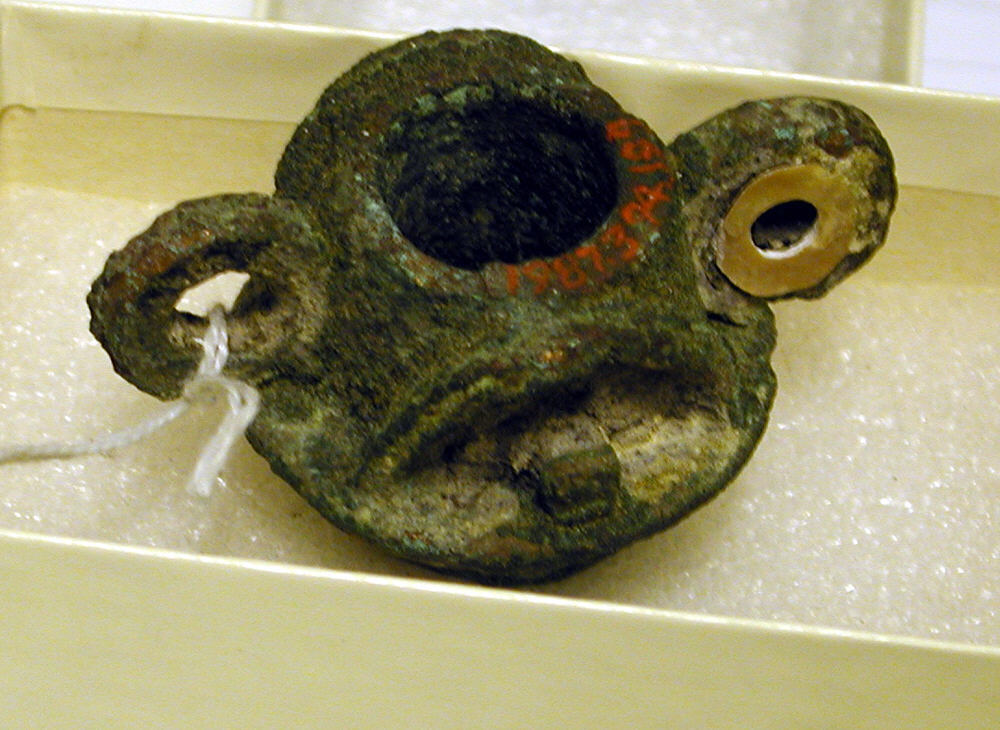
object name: mace head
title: Copper and Shell Janus Mace Head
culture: vicús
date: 300 BCE-200 CE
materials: copper, shell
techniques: casting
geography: peru